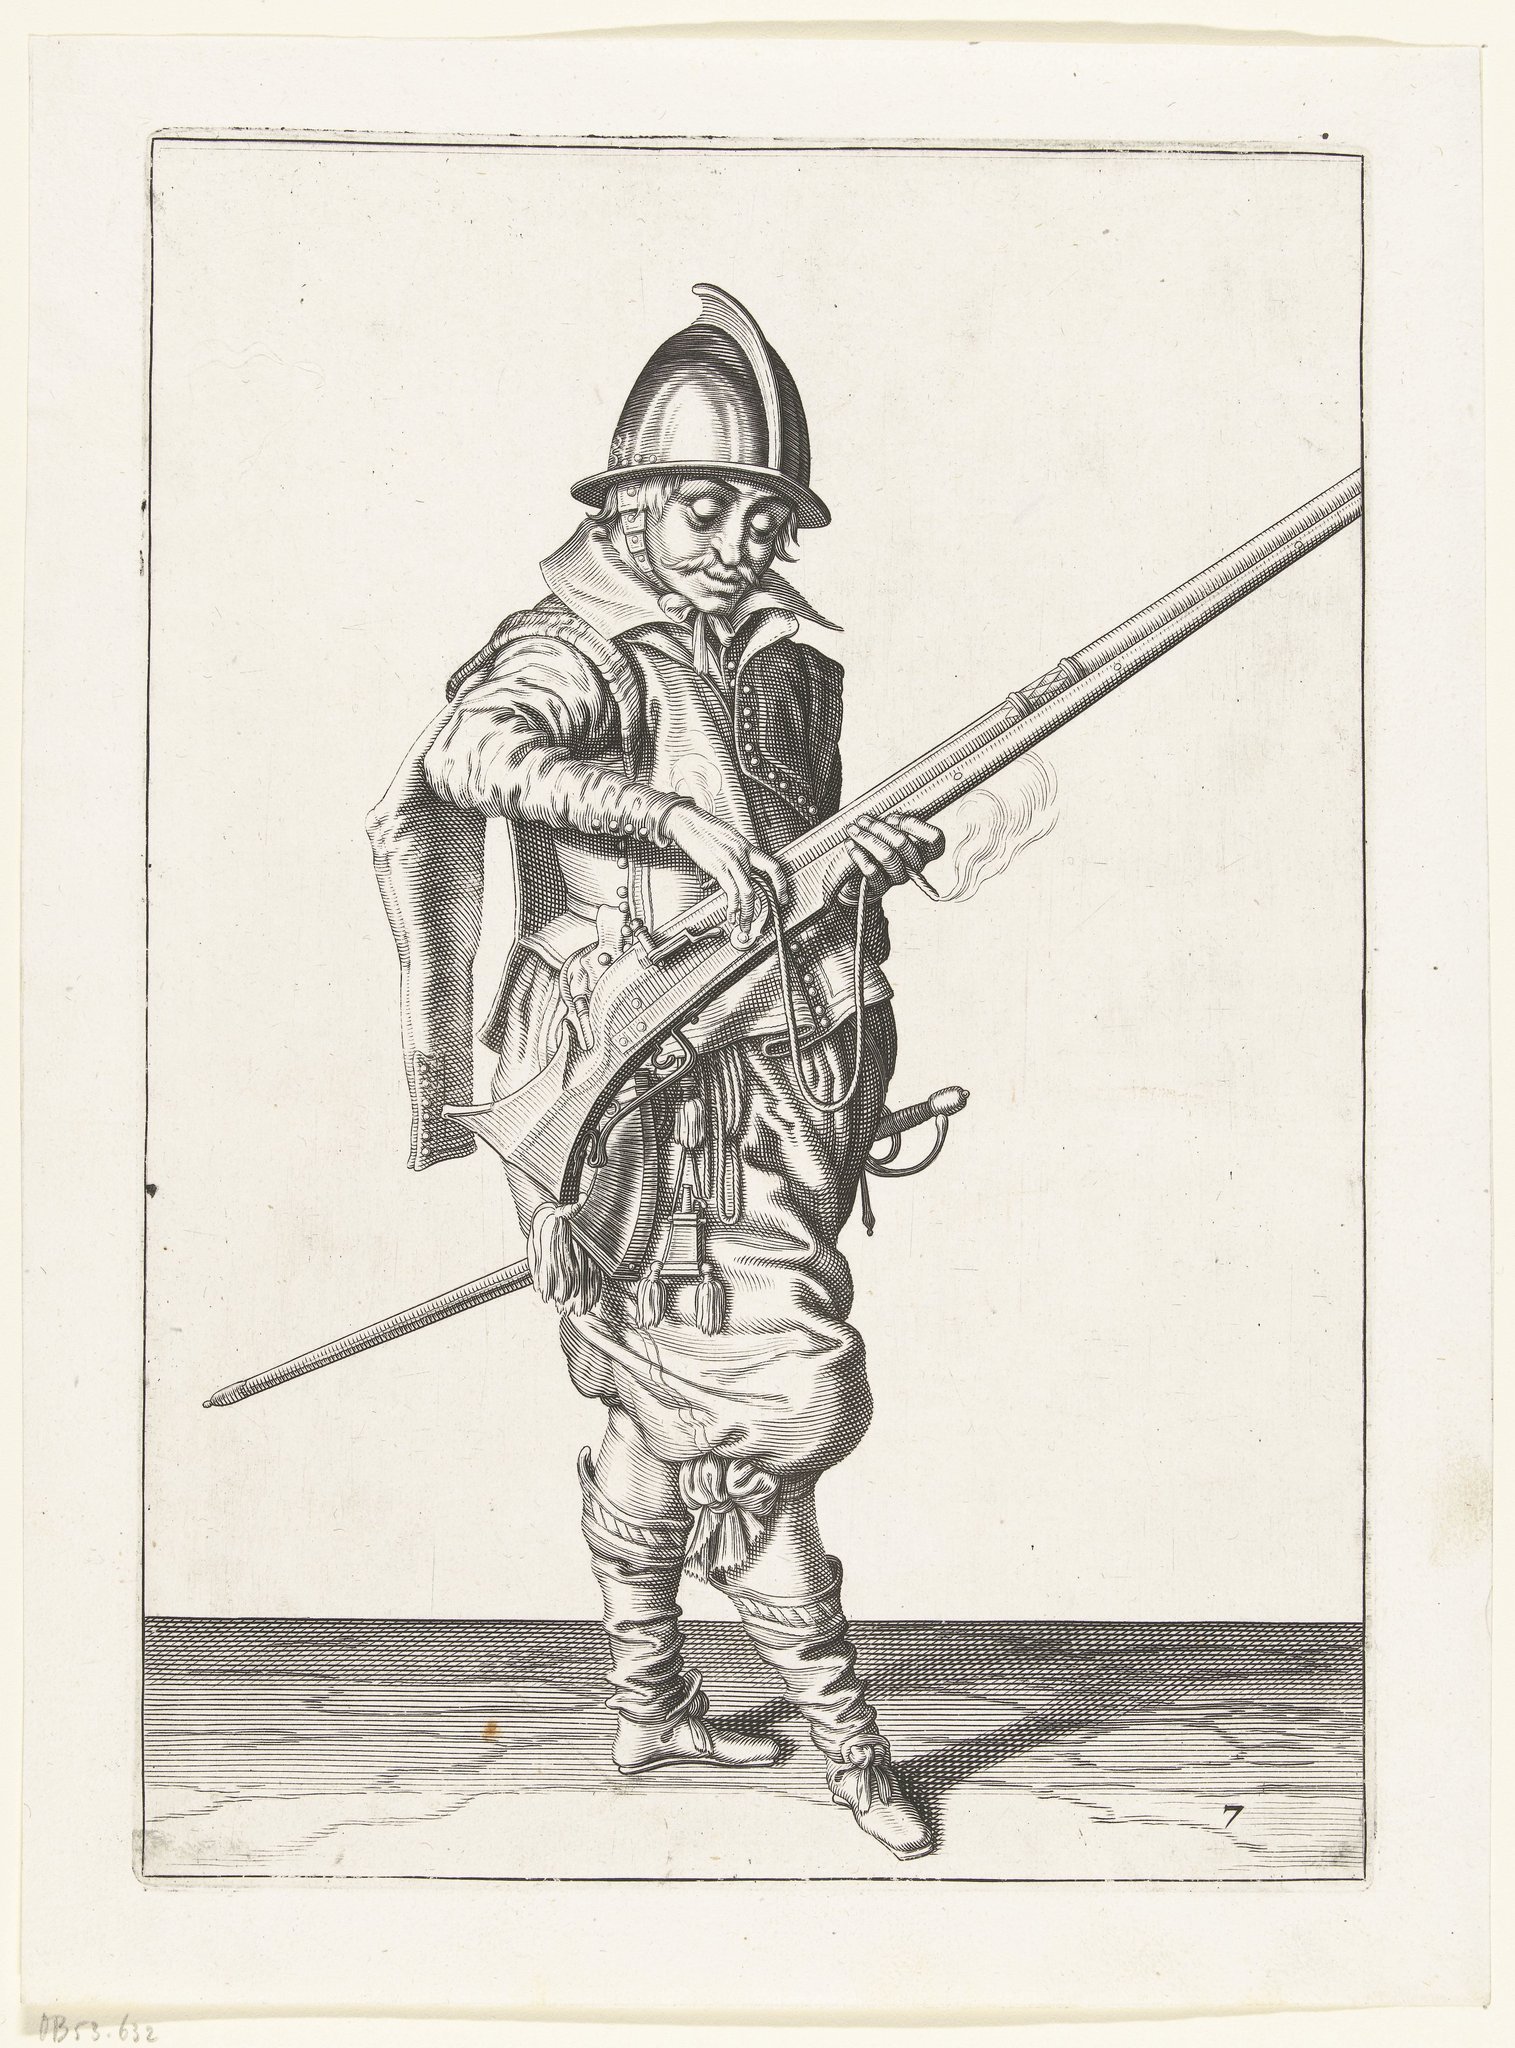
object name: print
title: Soldaat die zijn lont op de haan van zijn roer drukt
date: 1597-1607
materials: paper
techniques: engraving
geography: netherlands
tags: manoeuvre ~ military training, firearms: rifle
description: Een soldaat, ten voeten uit, naar rechts, die een roer (een bepaald type vuurwapen) met zijn linkerhand vasthoudt. Met zijn rechterhand drukt hij een brandende lont op de haan (onderdeel van het ontstekingsmechanisme) van zijn roer. Deze prent is onderdeel van de reeks van 42 genummerde prenten van roerschutters uit de Wapenhandelinghe.